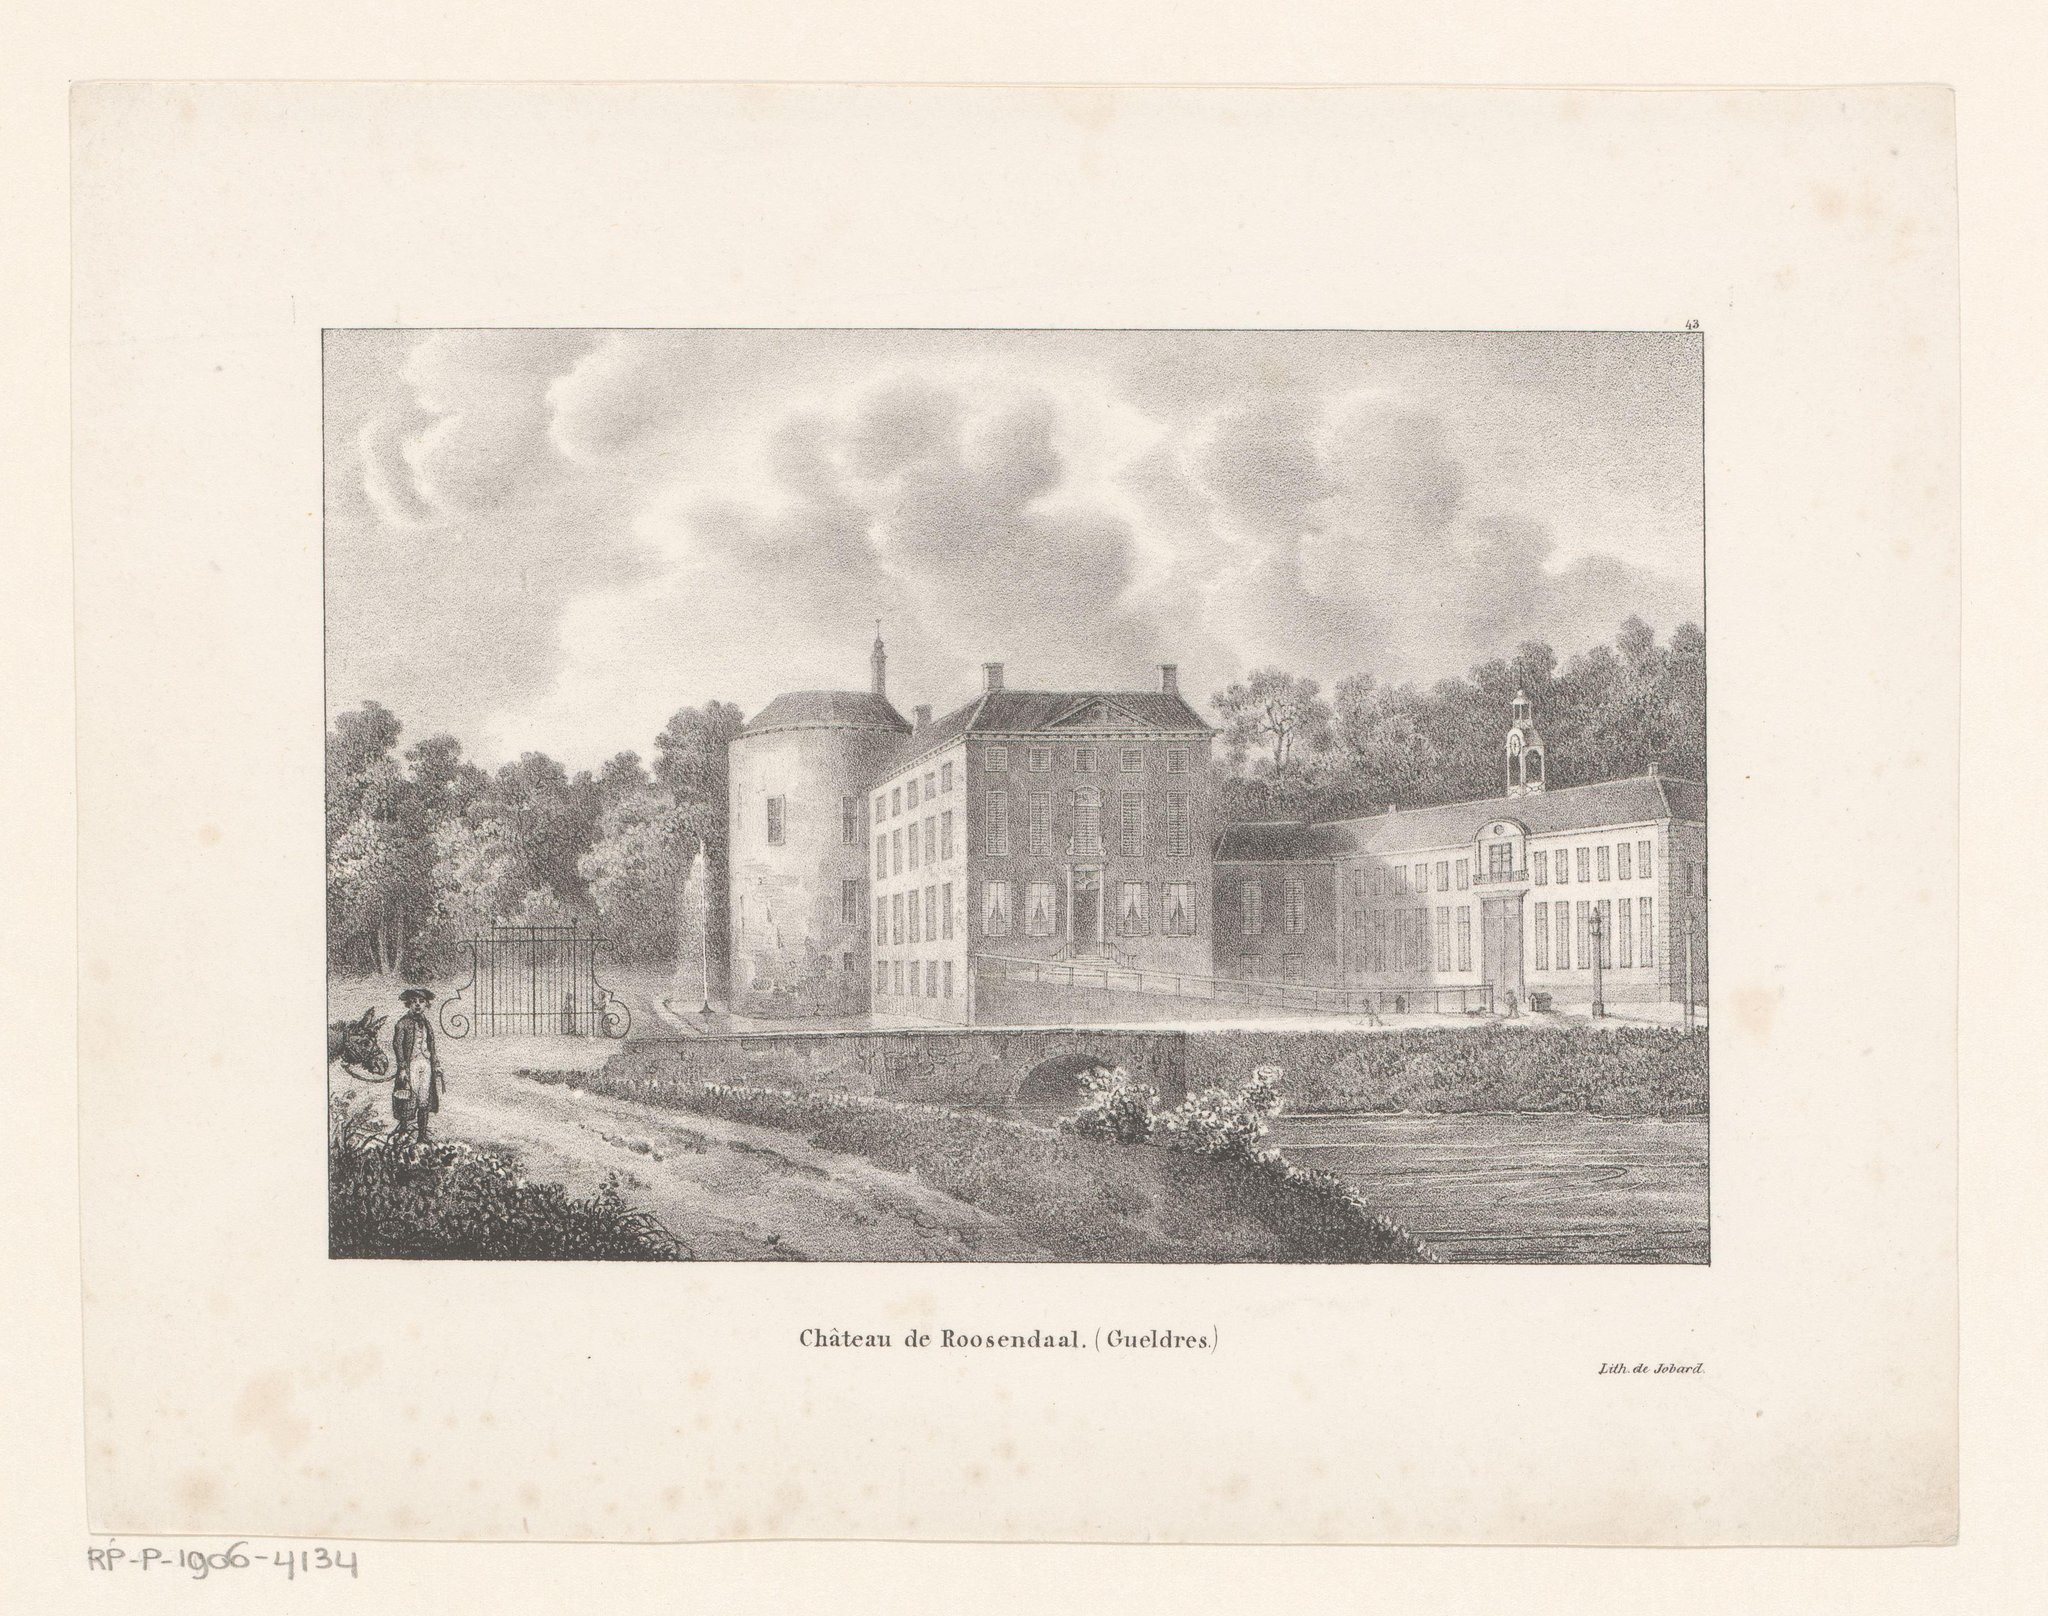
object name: print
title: Château de Roosendaal (Gueldres)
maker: Anonymous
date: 1827-1829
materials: paper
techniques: lithograph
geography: brussels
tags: castle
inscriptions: collector's mark: Lugt 2228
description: Prent verschenen in: Cloet, J.J. de. Châteaux et monumens des Pays-Bas faisant suite au voyage pittoresque. 2 dln. Brussel: Jobard frères, [1827-1829], dl. 1, nr. 43.